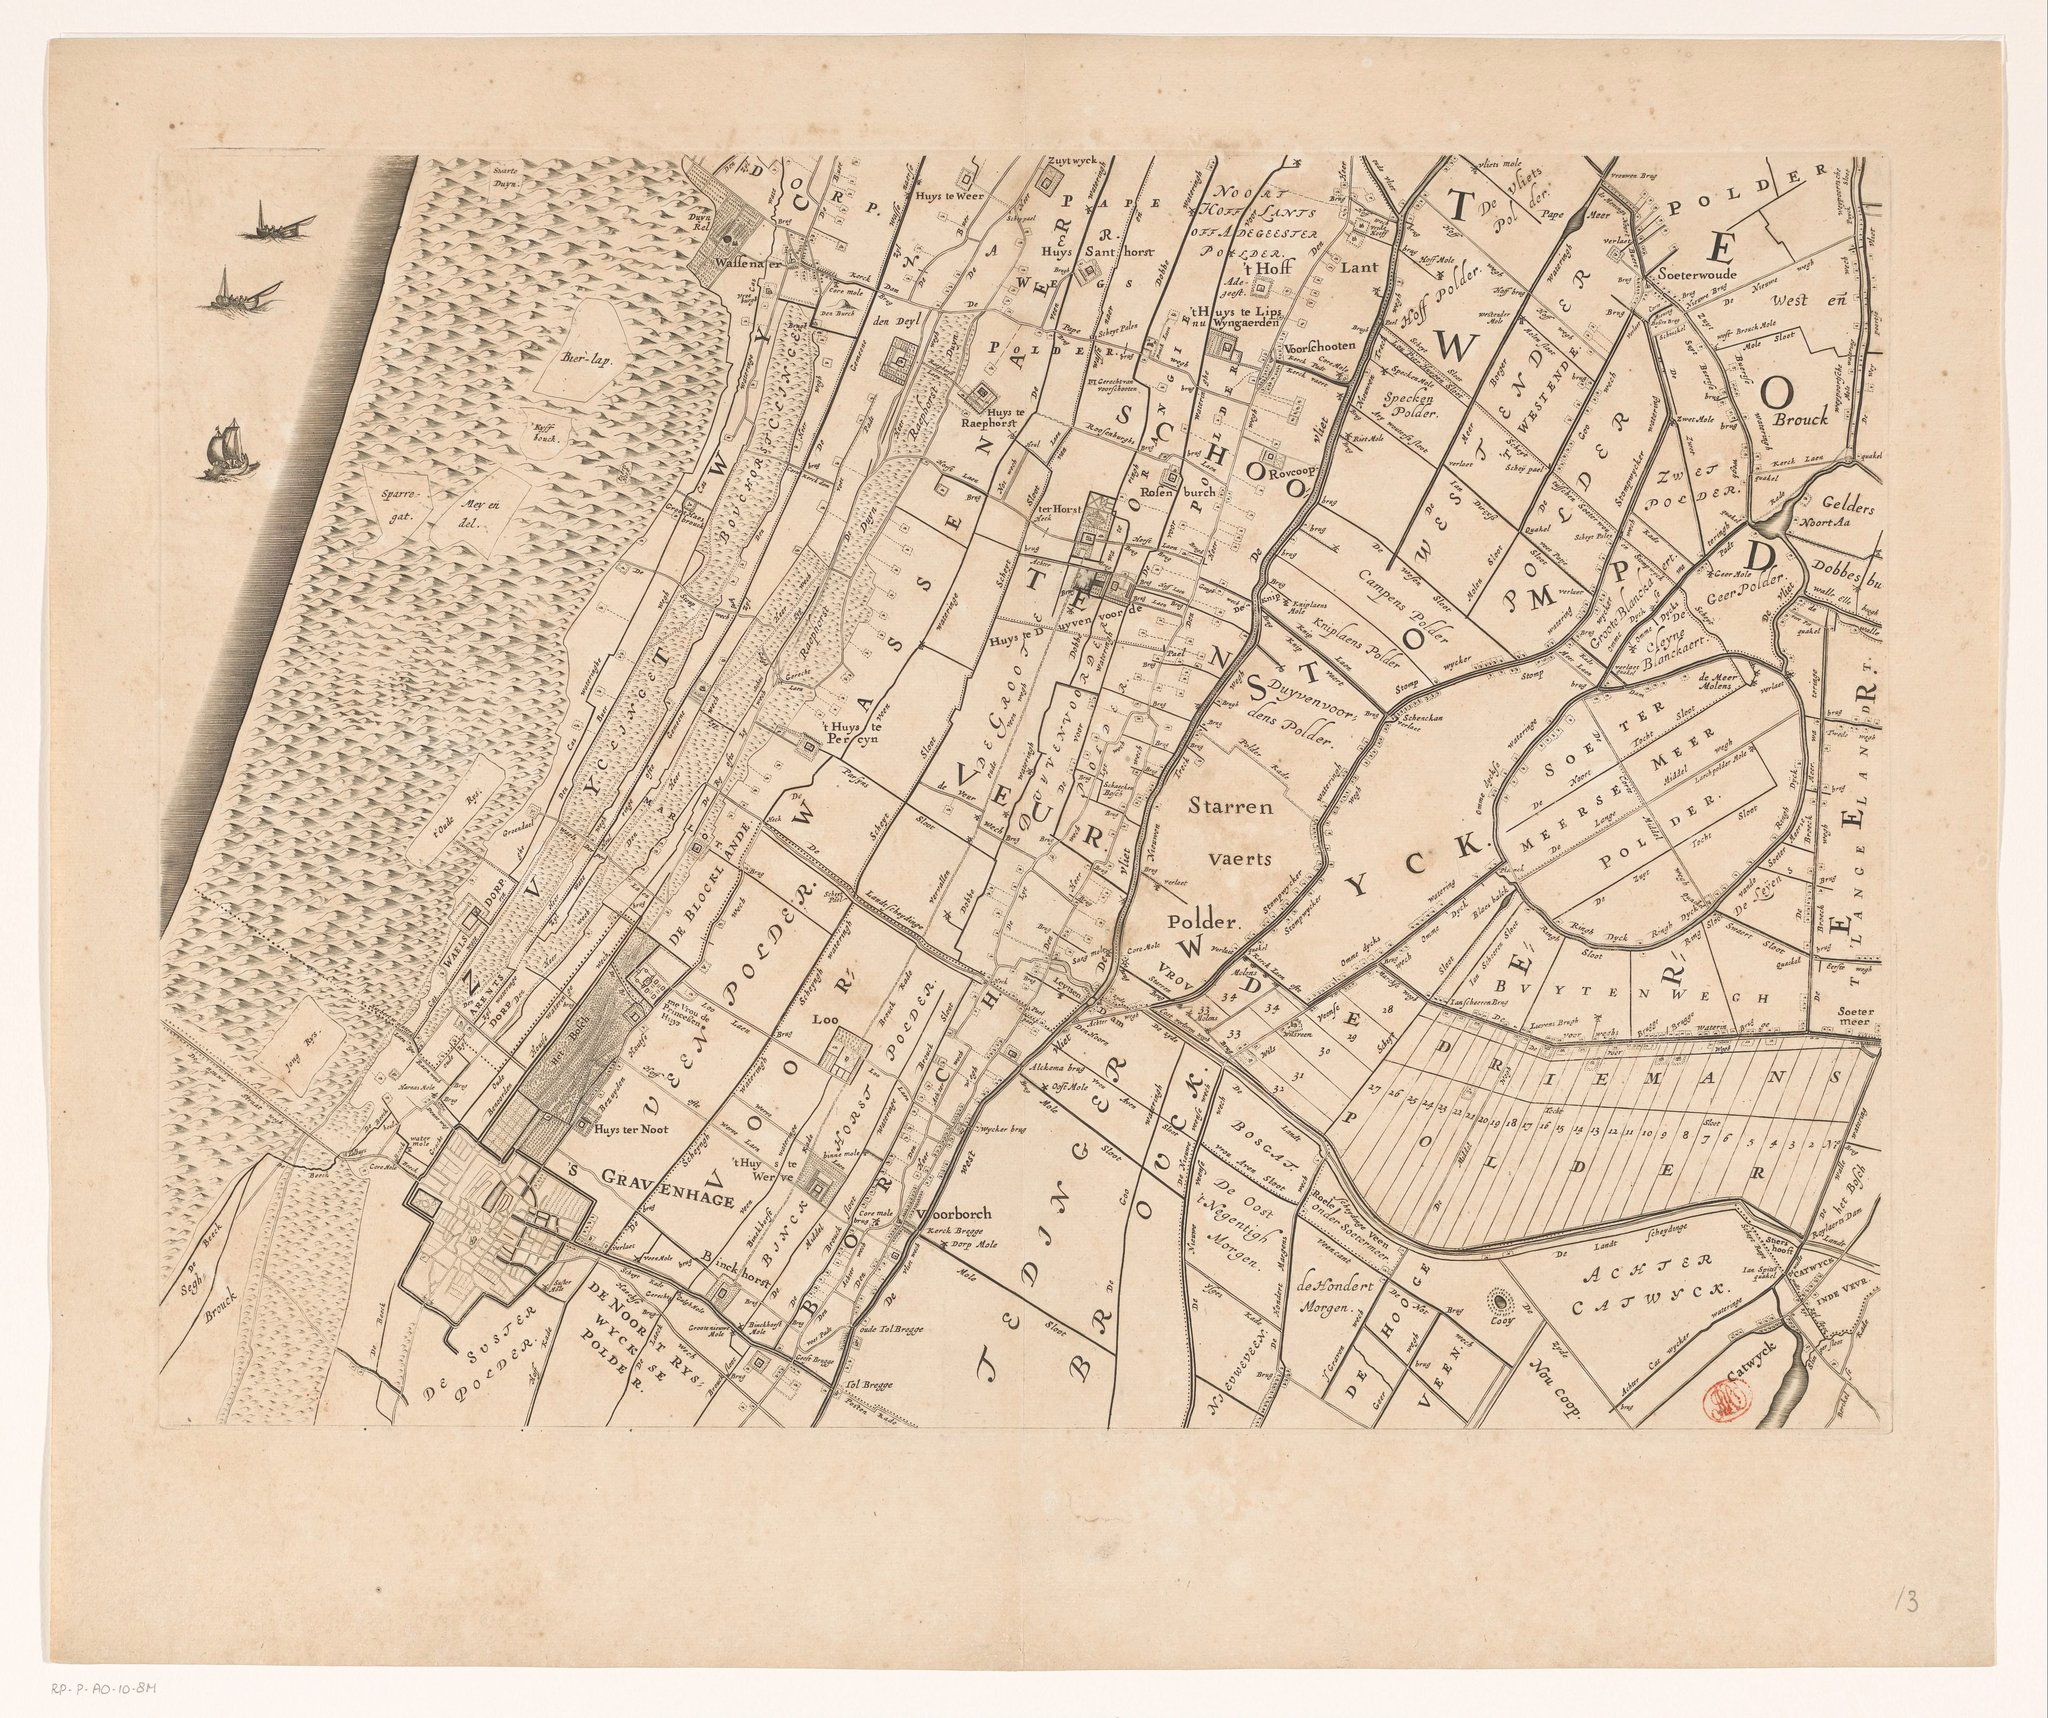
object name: map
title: Kaart van het Hoogheemraadschap van Rijnland (dertiende deel)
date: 1647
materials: paper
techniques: engraving, etching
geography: amsterdam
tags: maps of separate countries or regions, polder, reclaimed land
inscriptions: collector's mark: Lugt 195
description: Deze prent behoort tot de tweede druk (1687) van 'T' Hoogheymraedschap van Rhynland', een wandkaart van het Hoogheemraadschap van Rijnland bestaande uit een kaart van het gebied en een sierrand. Van deze kaart zijn voor zover na te gaan drie verschillende drukken bekend, uit respectievelijk 1647, 1687 en 1746. Het kaartdeel is gedrukt van twaalf platen die voor elke druk zijn aangepast. Het vijfde blad van het kaartdeel (RP-P-AO-10-8H) is in of na 1766 nog een keer bijgewerkt en los uitgegeven. Hierdoor zijn van het vijfde blad vier staten bekend en van de overige bladen drie. Zie documentatie voor meer informatie. Bij de eerste en tweede druk hoort een sierrand met daarop de titel, wapenschilden en octrooiverleningen. Delen van de zijkant van de rand van de eerste druk zijn voor de tweede druk herbruikt, terwijl andere delen van de zijkanten en de hele bovenkant nieuw zijn gemaakt door Romeyn de Hooghe. De derde druk heeft slechts een nieuw gemaakte titelstrook langs de bovenkant.